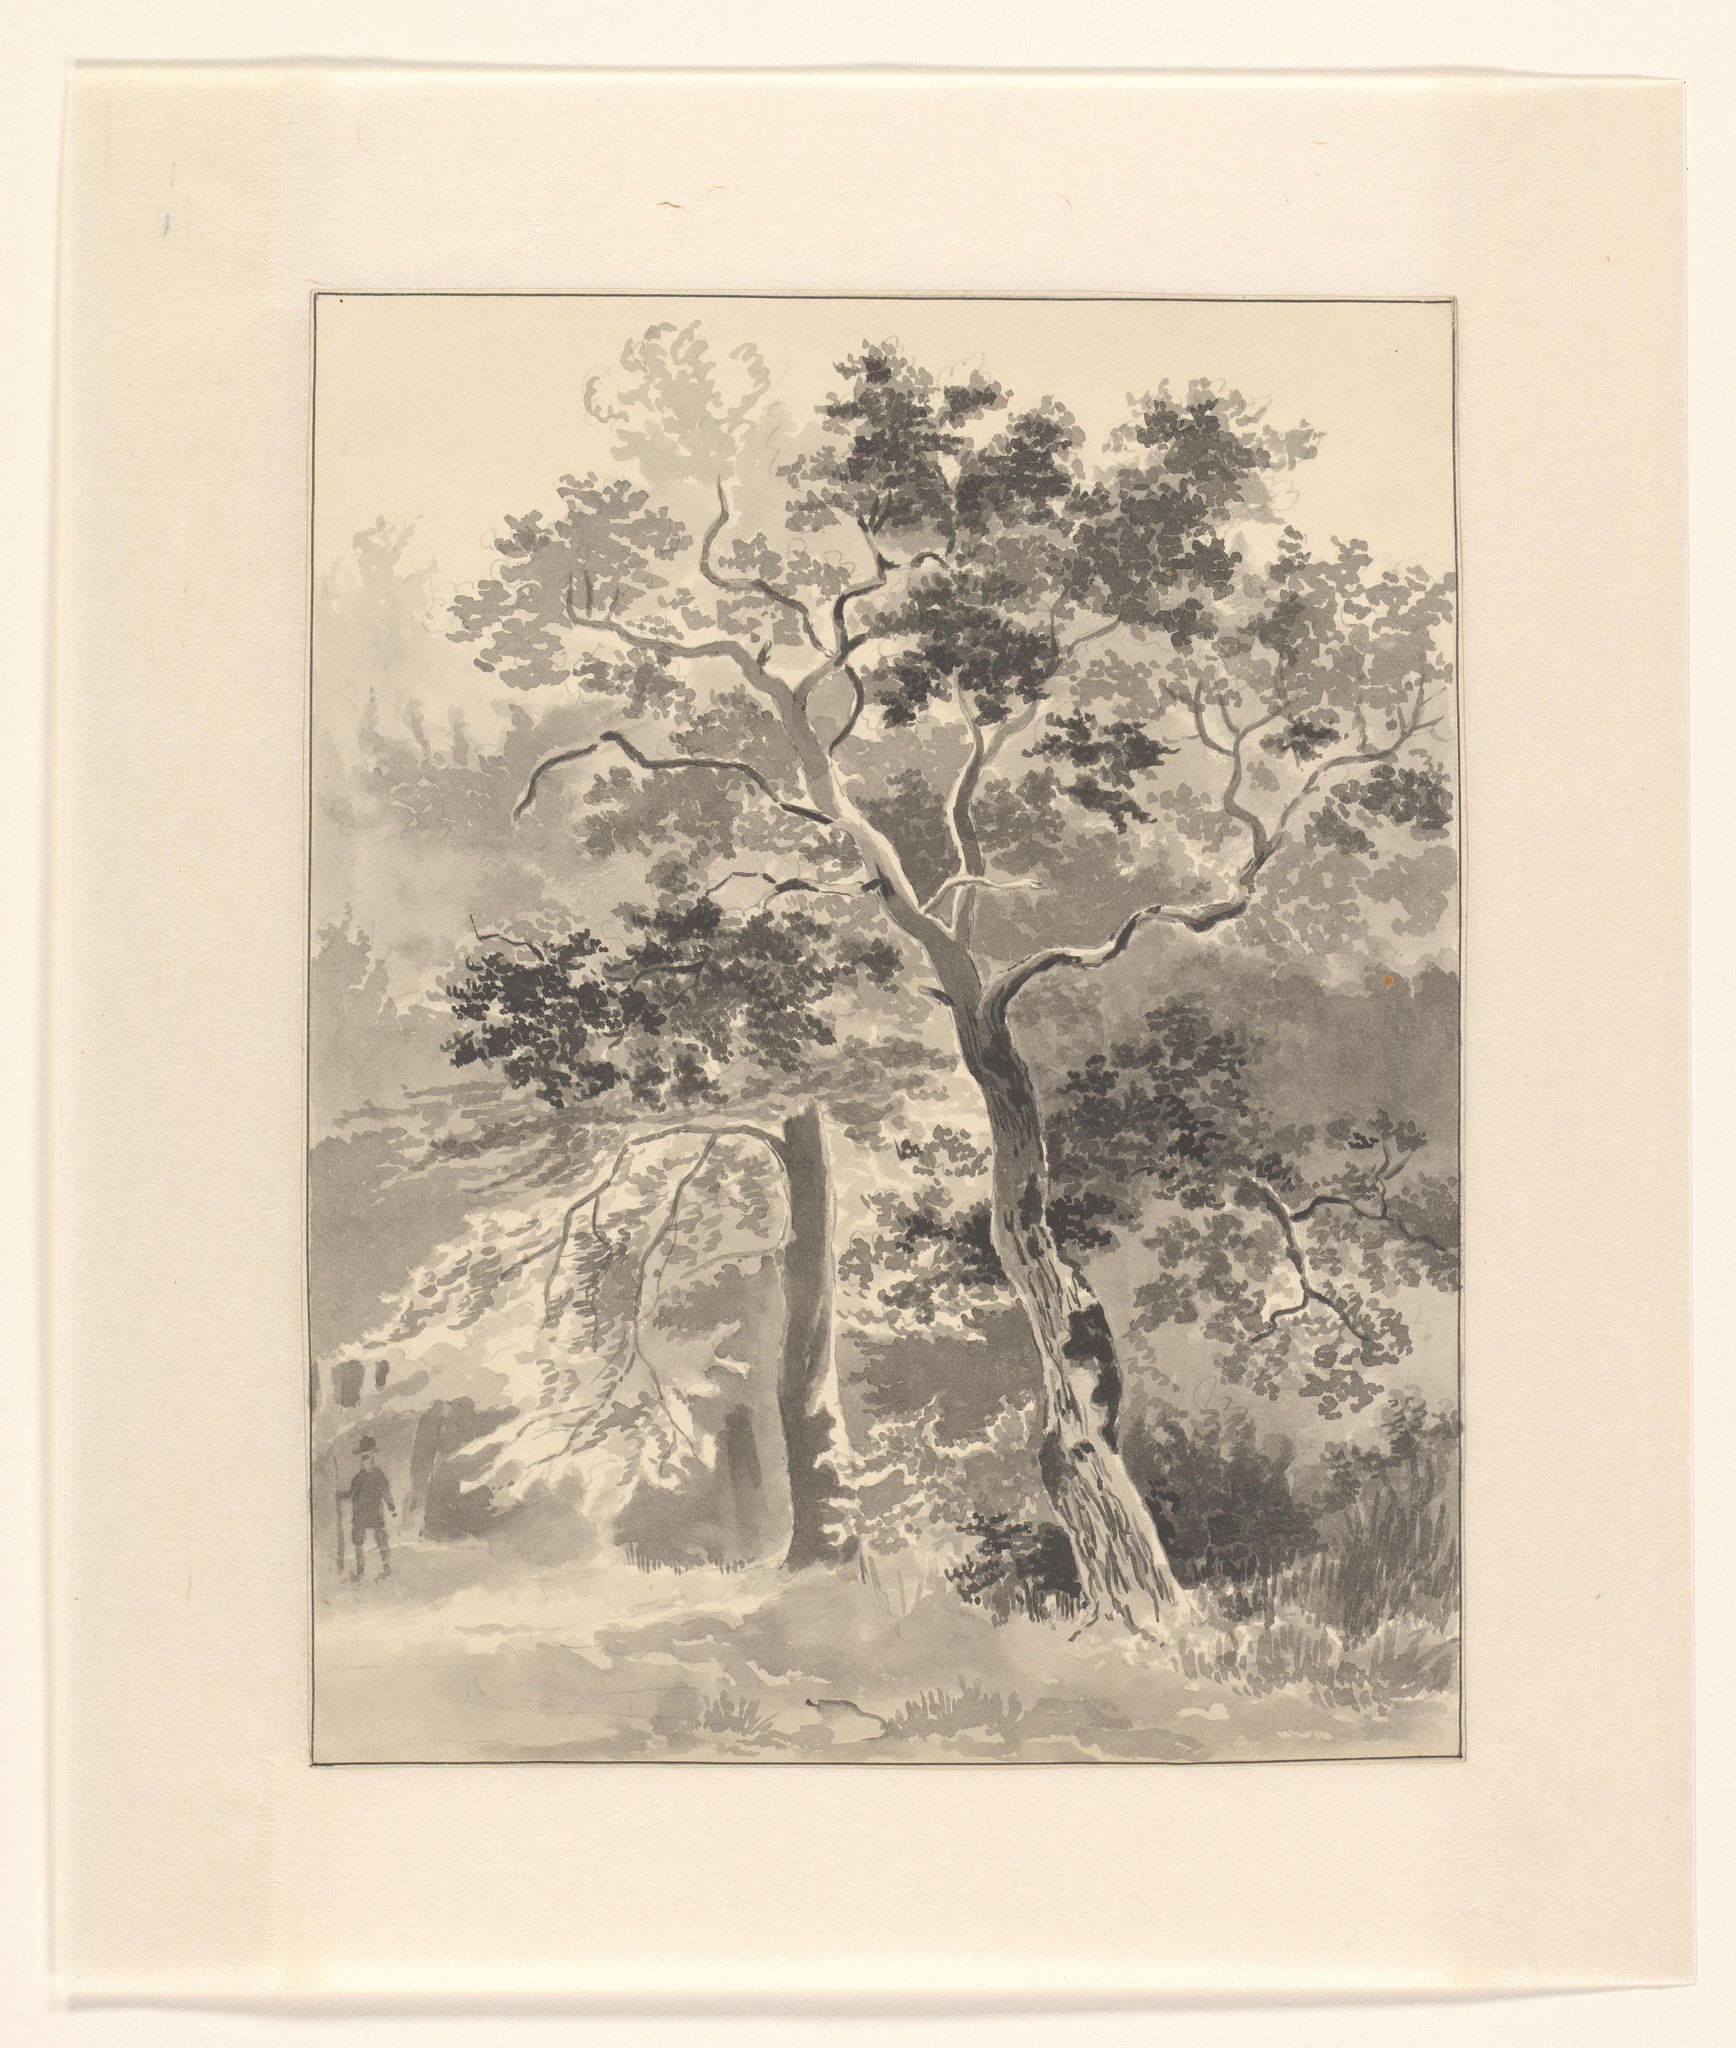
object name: drawing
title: Jager in een bos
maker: johannes van reijn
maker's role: draughtsman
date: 1800-1900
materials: paper, pencil, watercolor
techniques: brush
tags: forest, wood (+ landscape with figures, staffage)